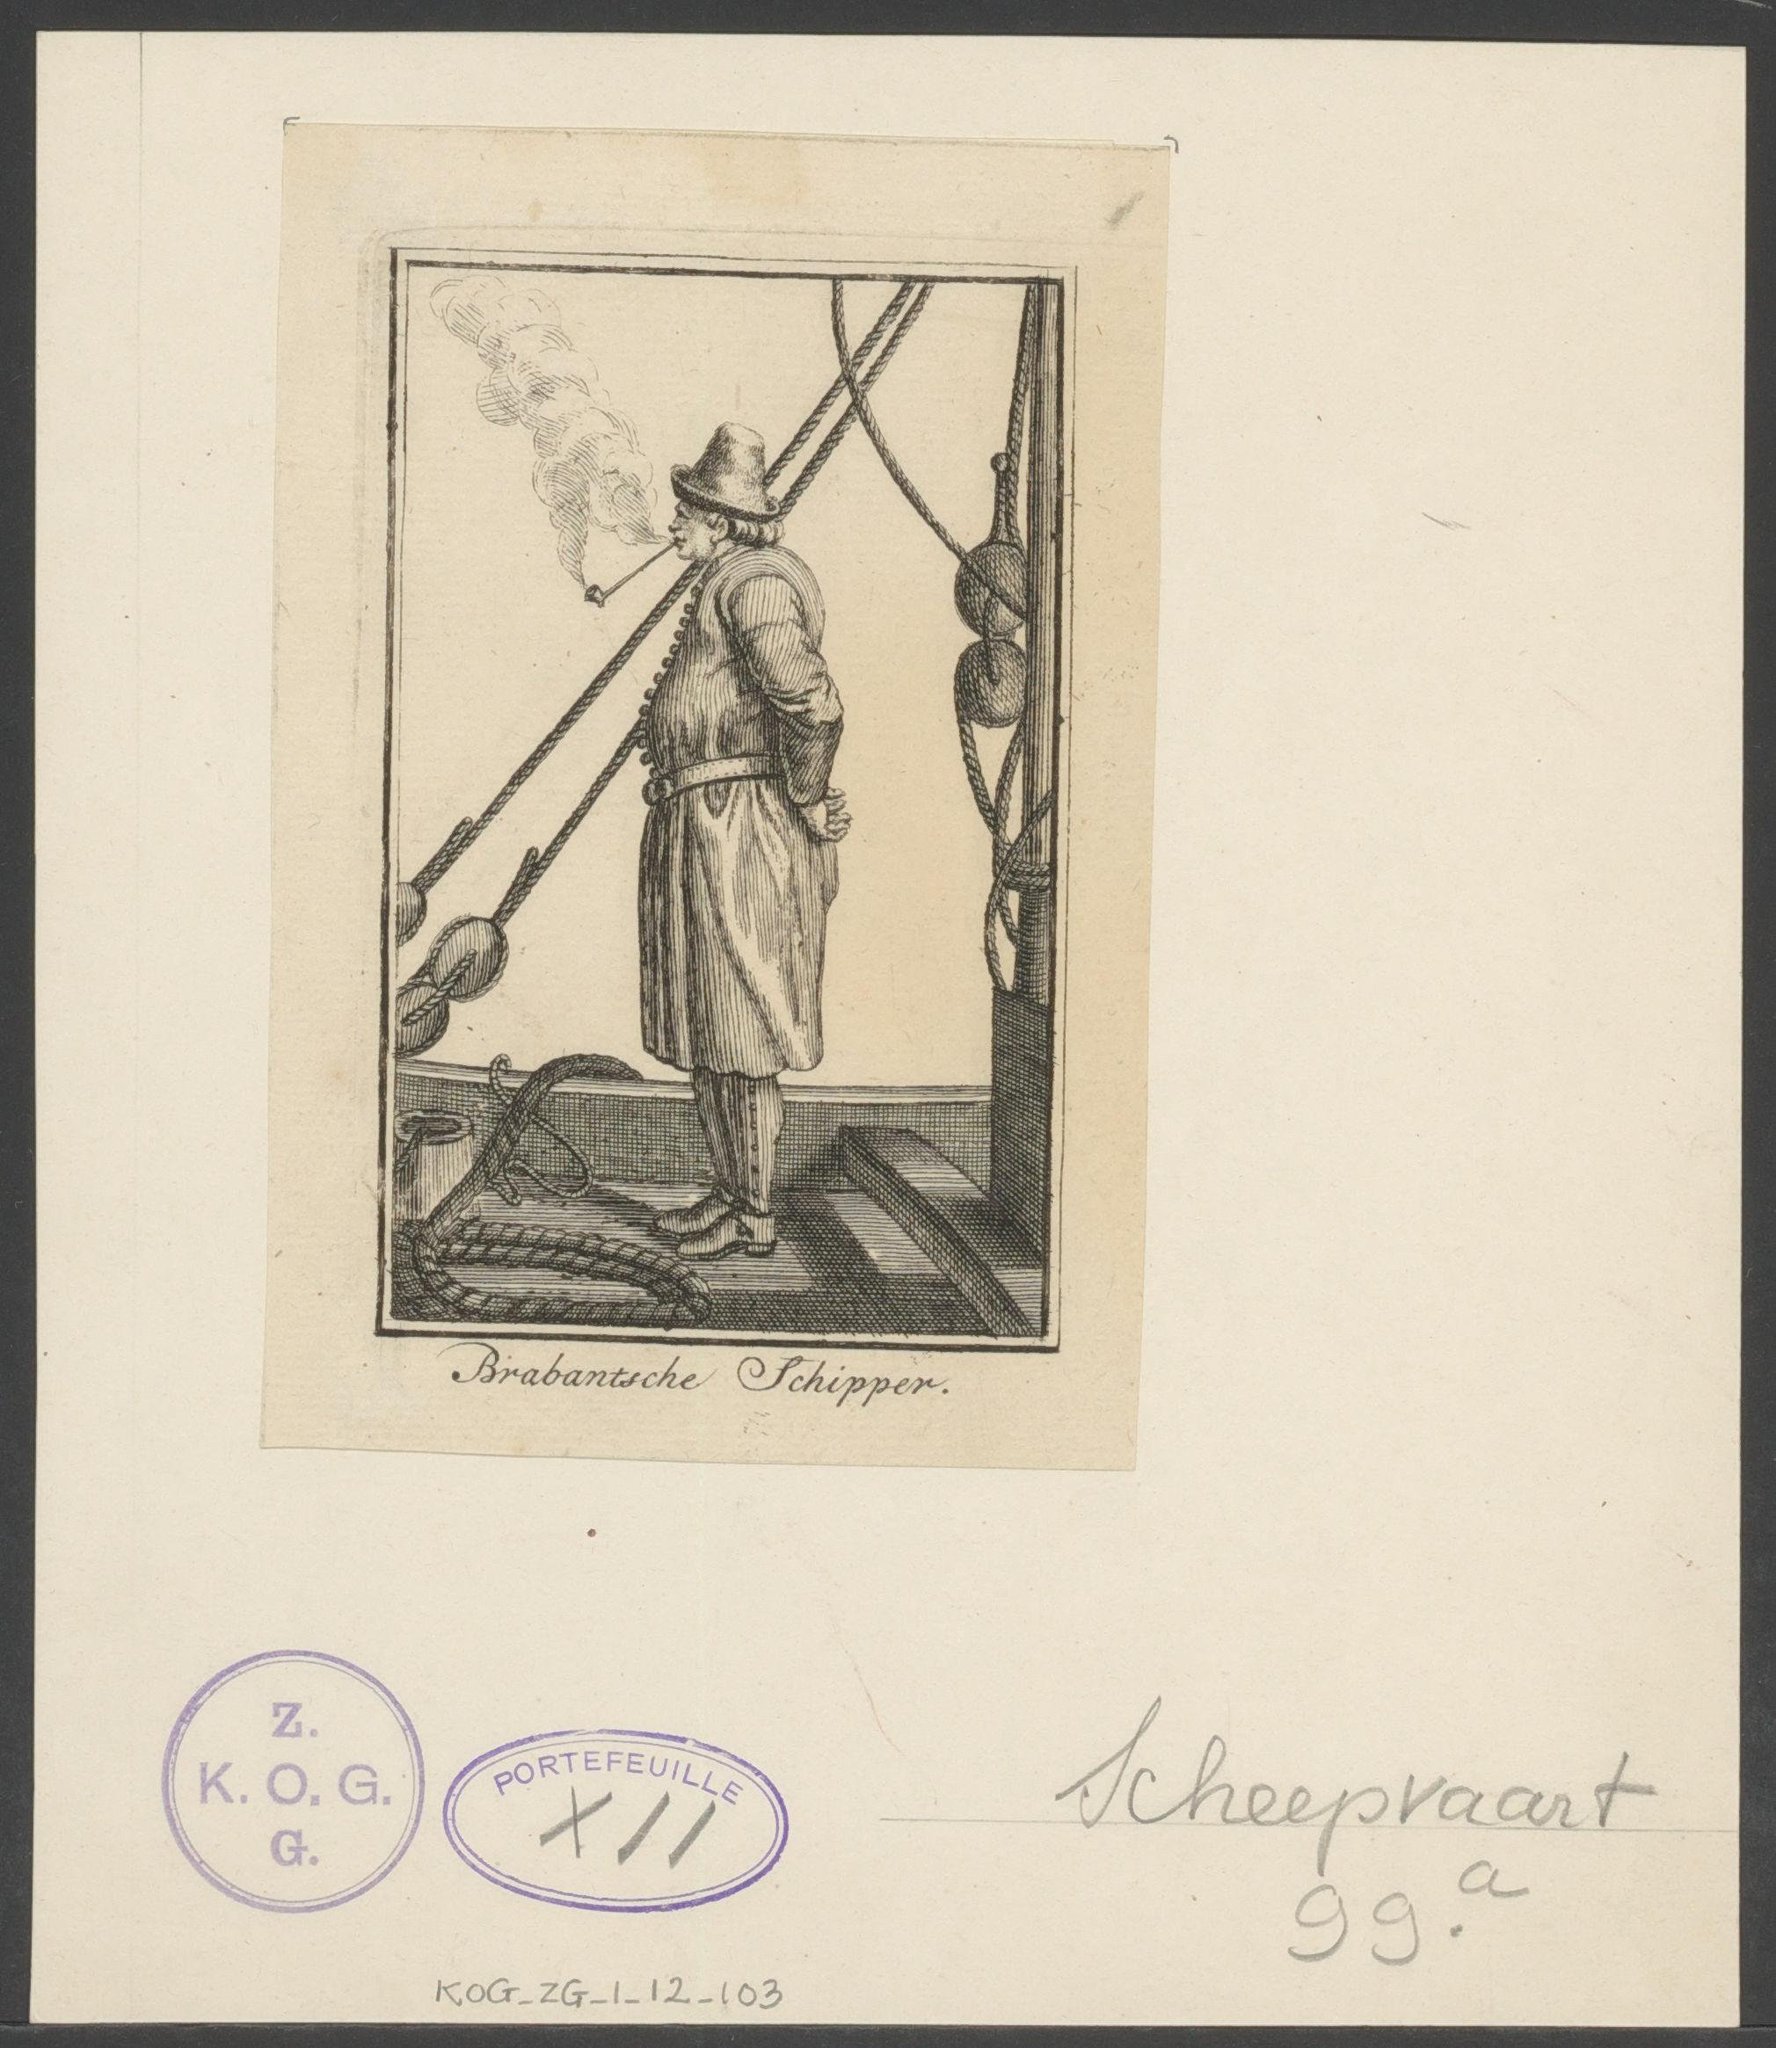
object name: costume print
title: Brabantse schipper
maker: Anonymous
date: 1690-1749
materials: paper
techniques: engraving, etching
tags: seaman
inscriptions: stamp, collector's mark: Lugt 1641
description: Staande man met de handen op zijn rug op een schip. Onderwerpsrubrieken binnen de Atlas Zeden en Gewoonten: Handel, Nijverheid en Verkeer, Scheepsvaart.